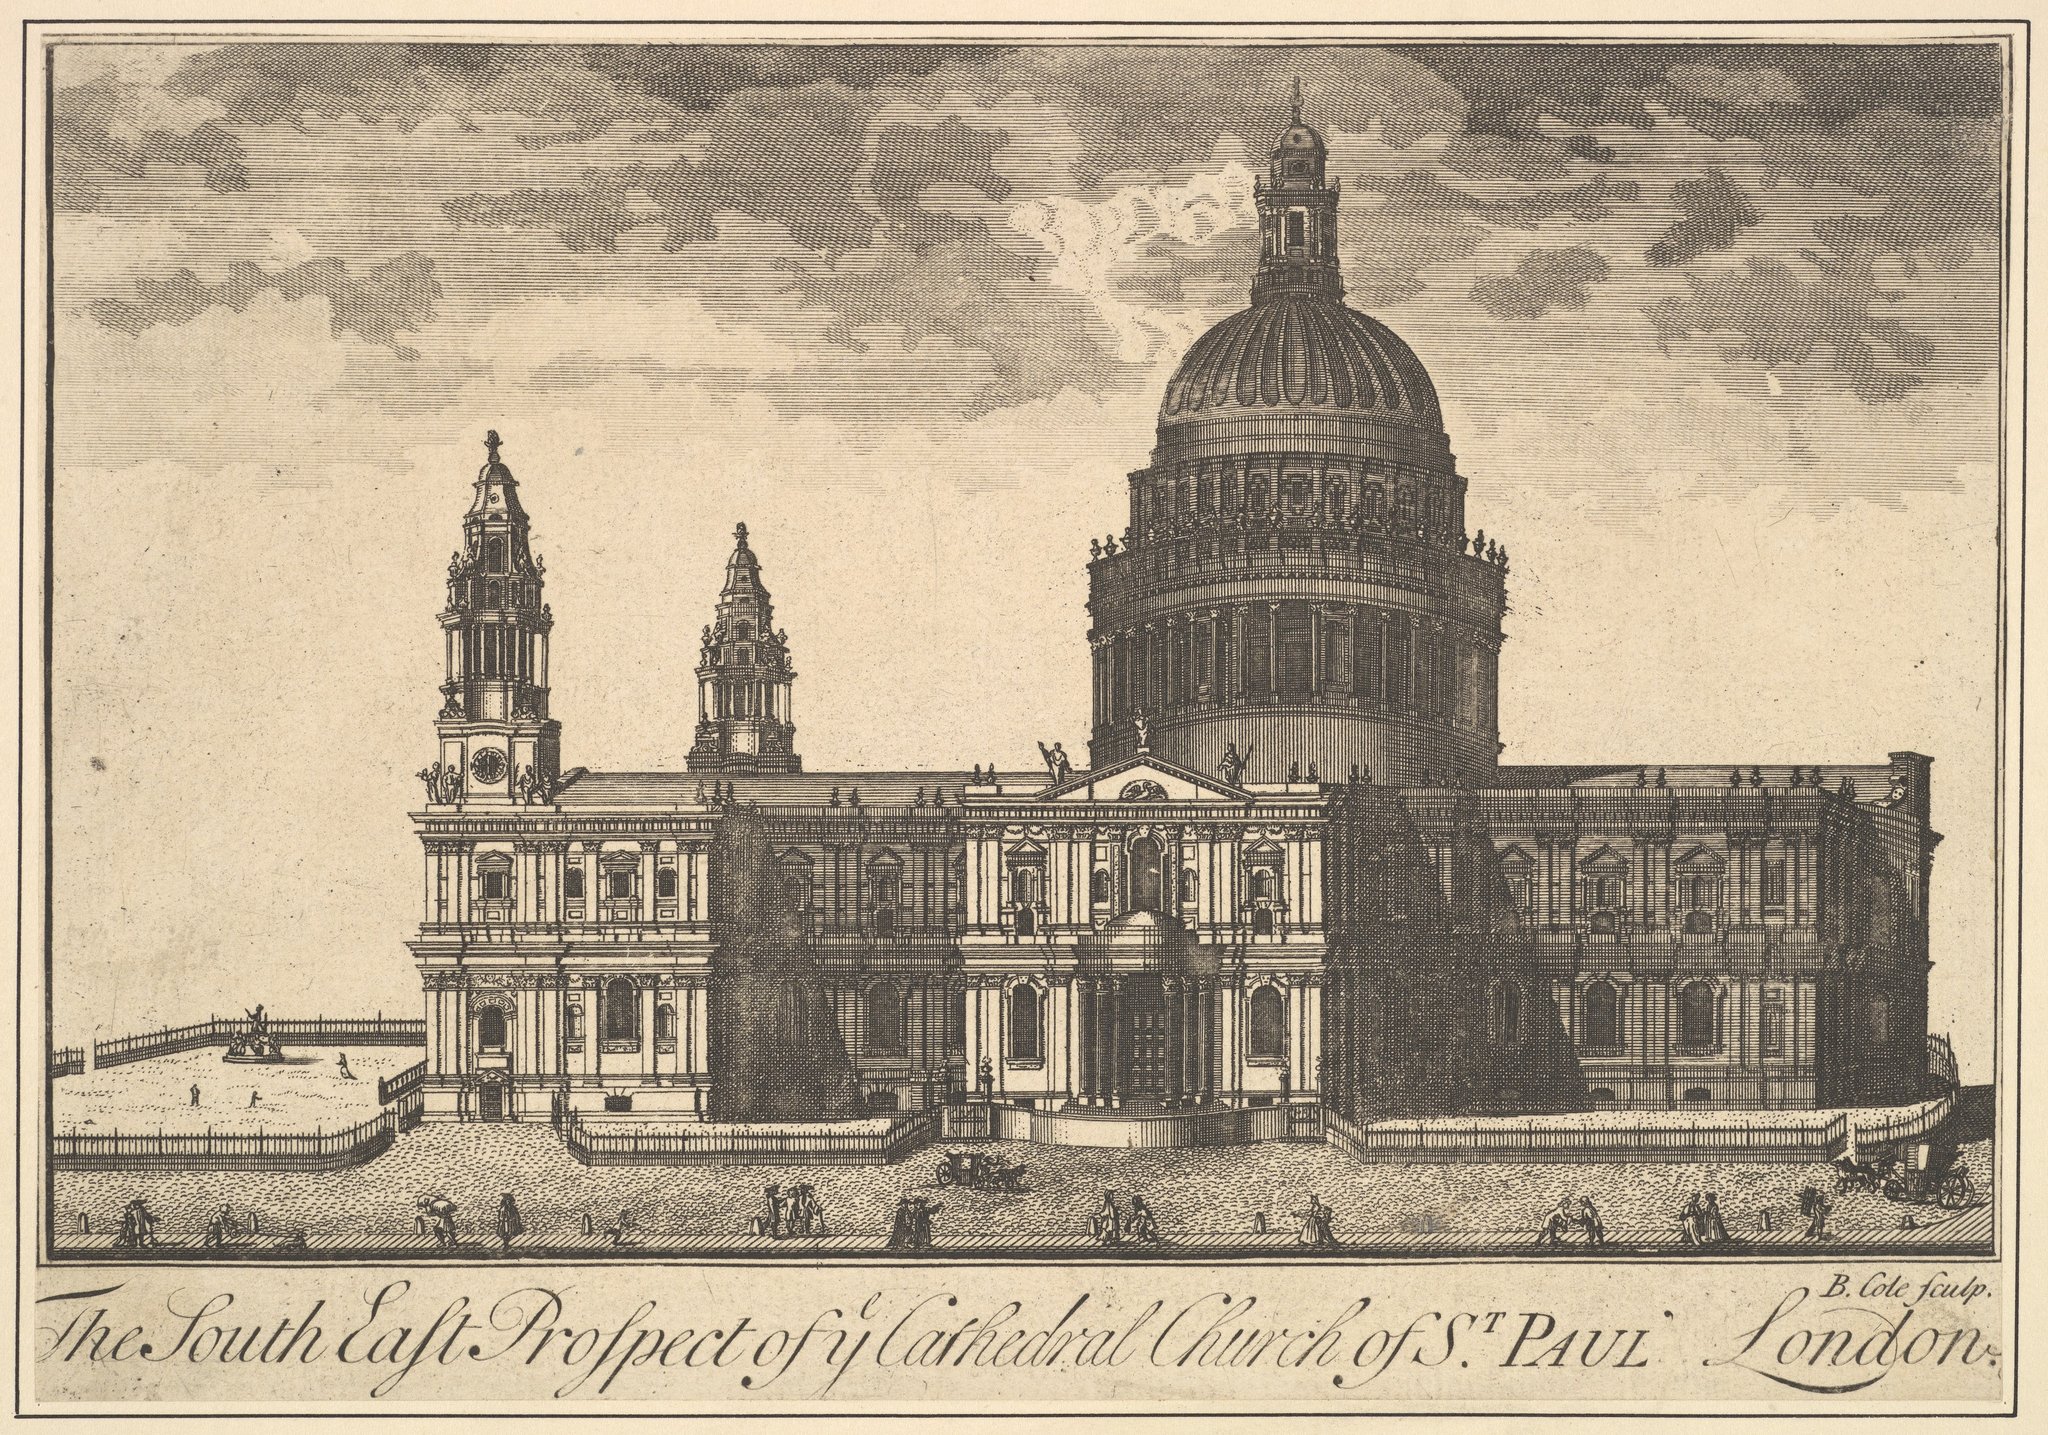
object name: print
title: The South East Prospect of the Cathedral Church of St. Paul, London, from "Overton's Prospects"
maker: benjamin cole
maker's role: artist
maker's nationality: british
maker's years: 1697-1783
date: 1720-1730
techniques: engraving, etching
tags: cathedrals,london